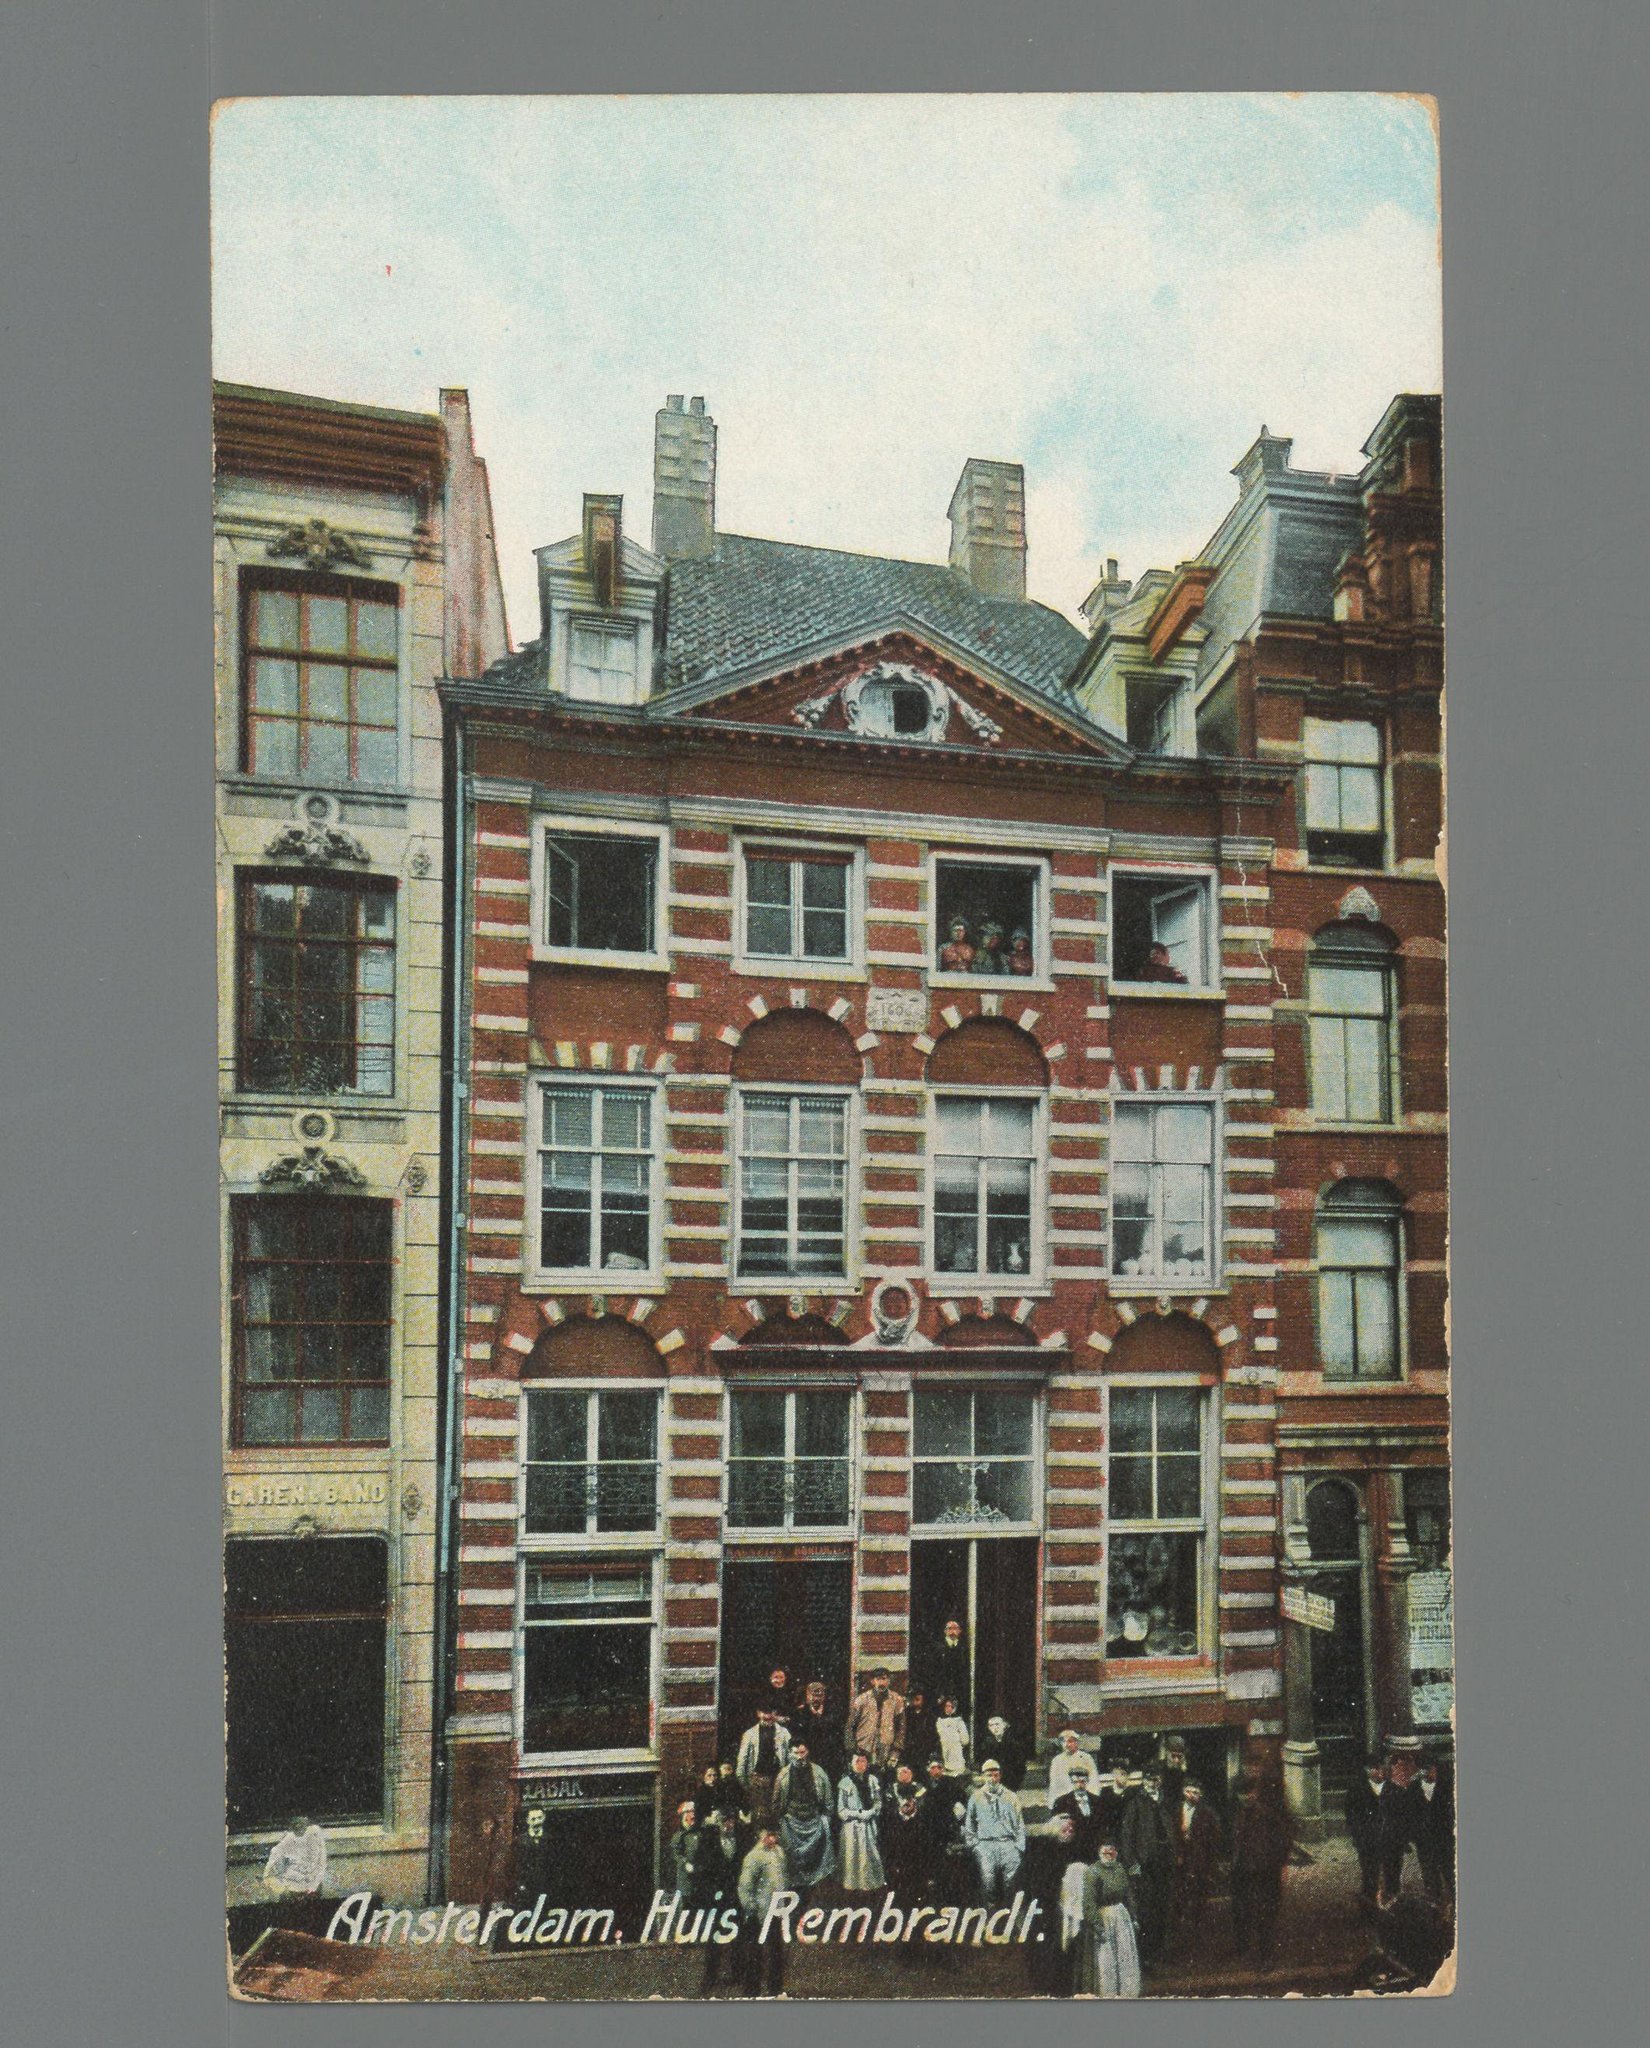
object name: ansichtkaart, prentbriefkaart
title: Amsterdam. Huis Rembrandt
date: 1906-1911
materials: cardboard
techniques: lithograph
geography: amsterdam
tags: permanent exhibition, museum, façade (of house or building)